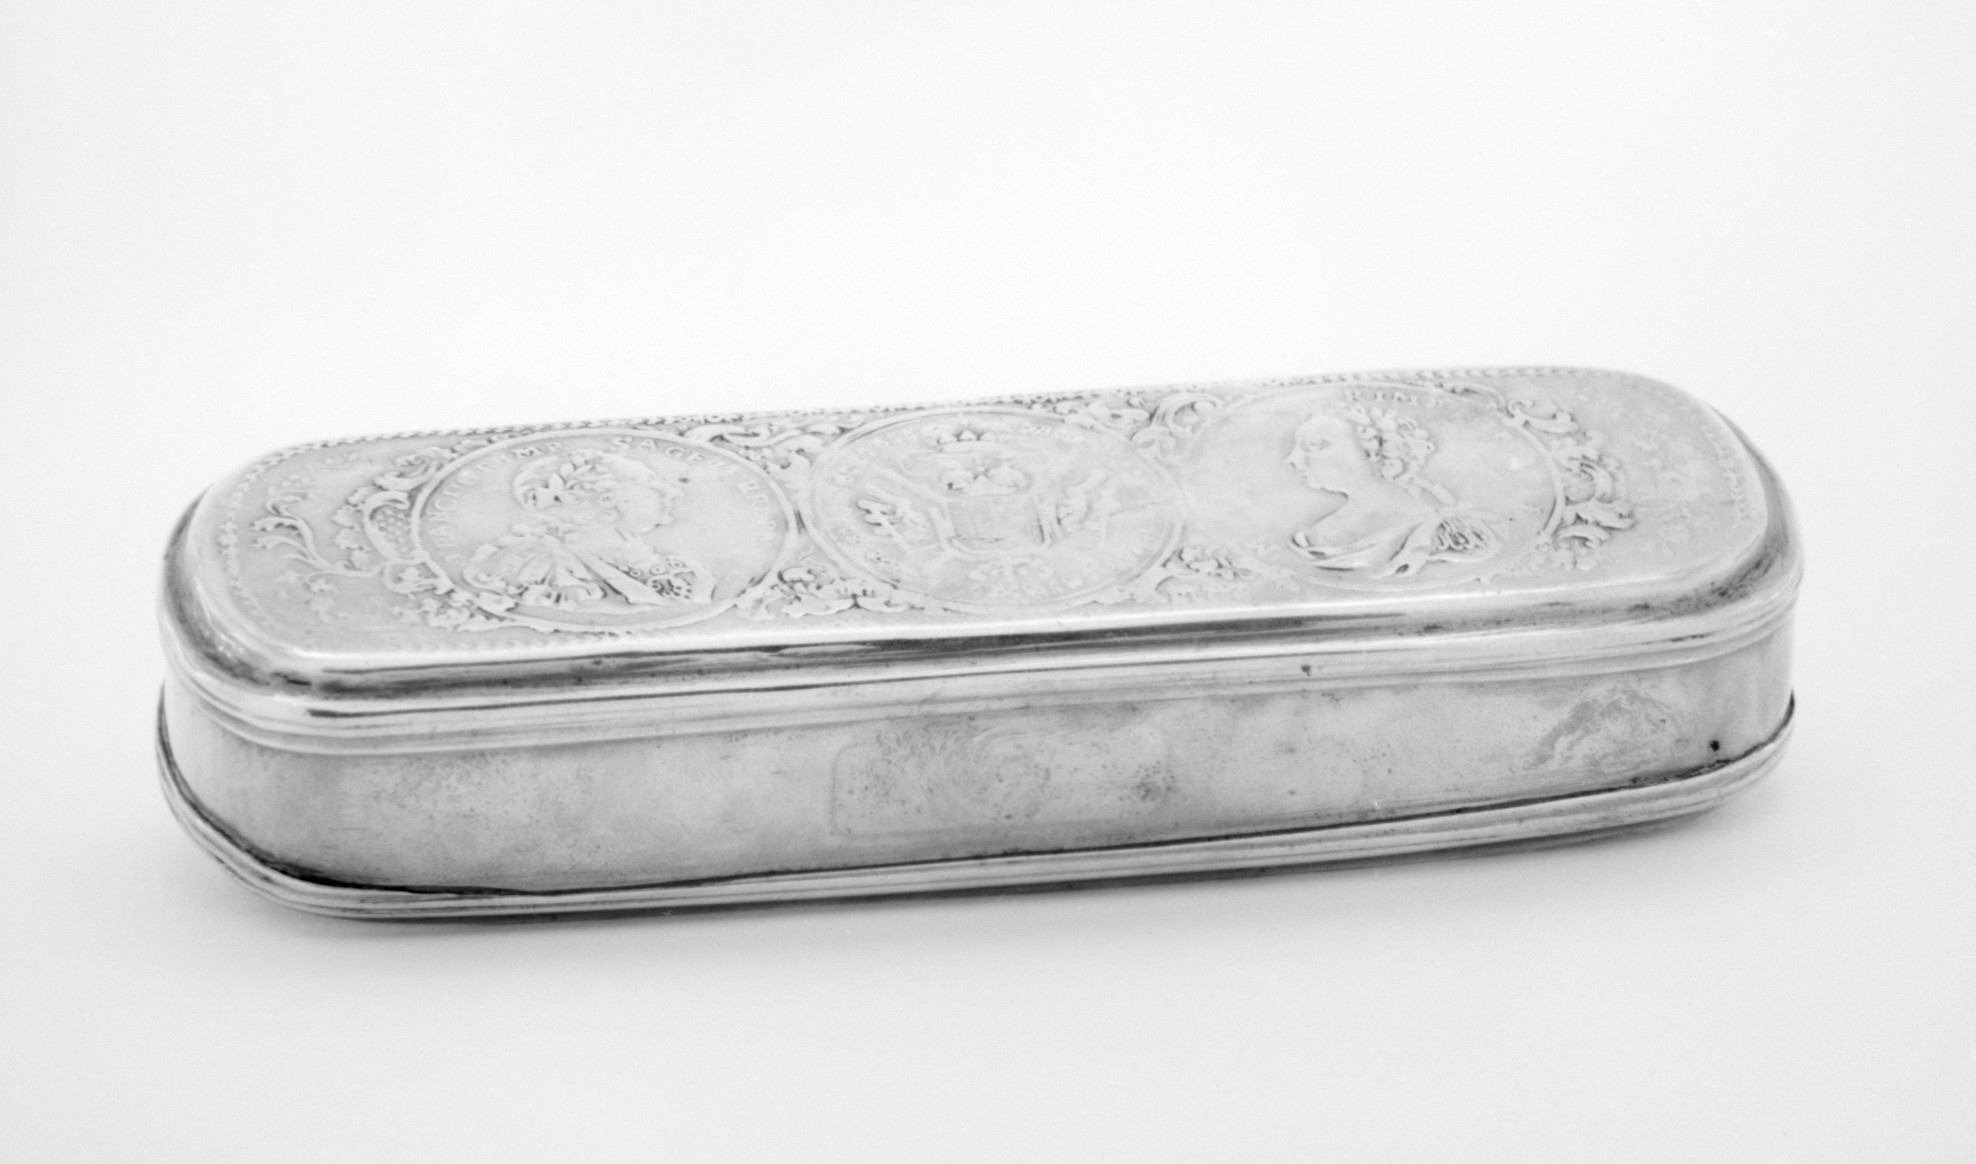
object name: tobacco box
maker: i. h. becker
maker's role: artist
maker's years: 1725-1825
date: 1701-1800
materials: brass, copper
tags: profiles